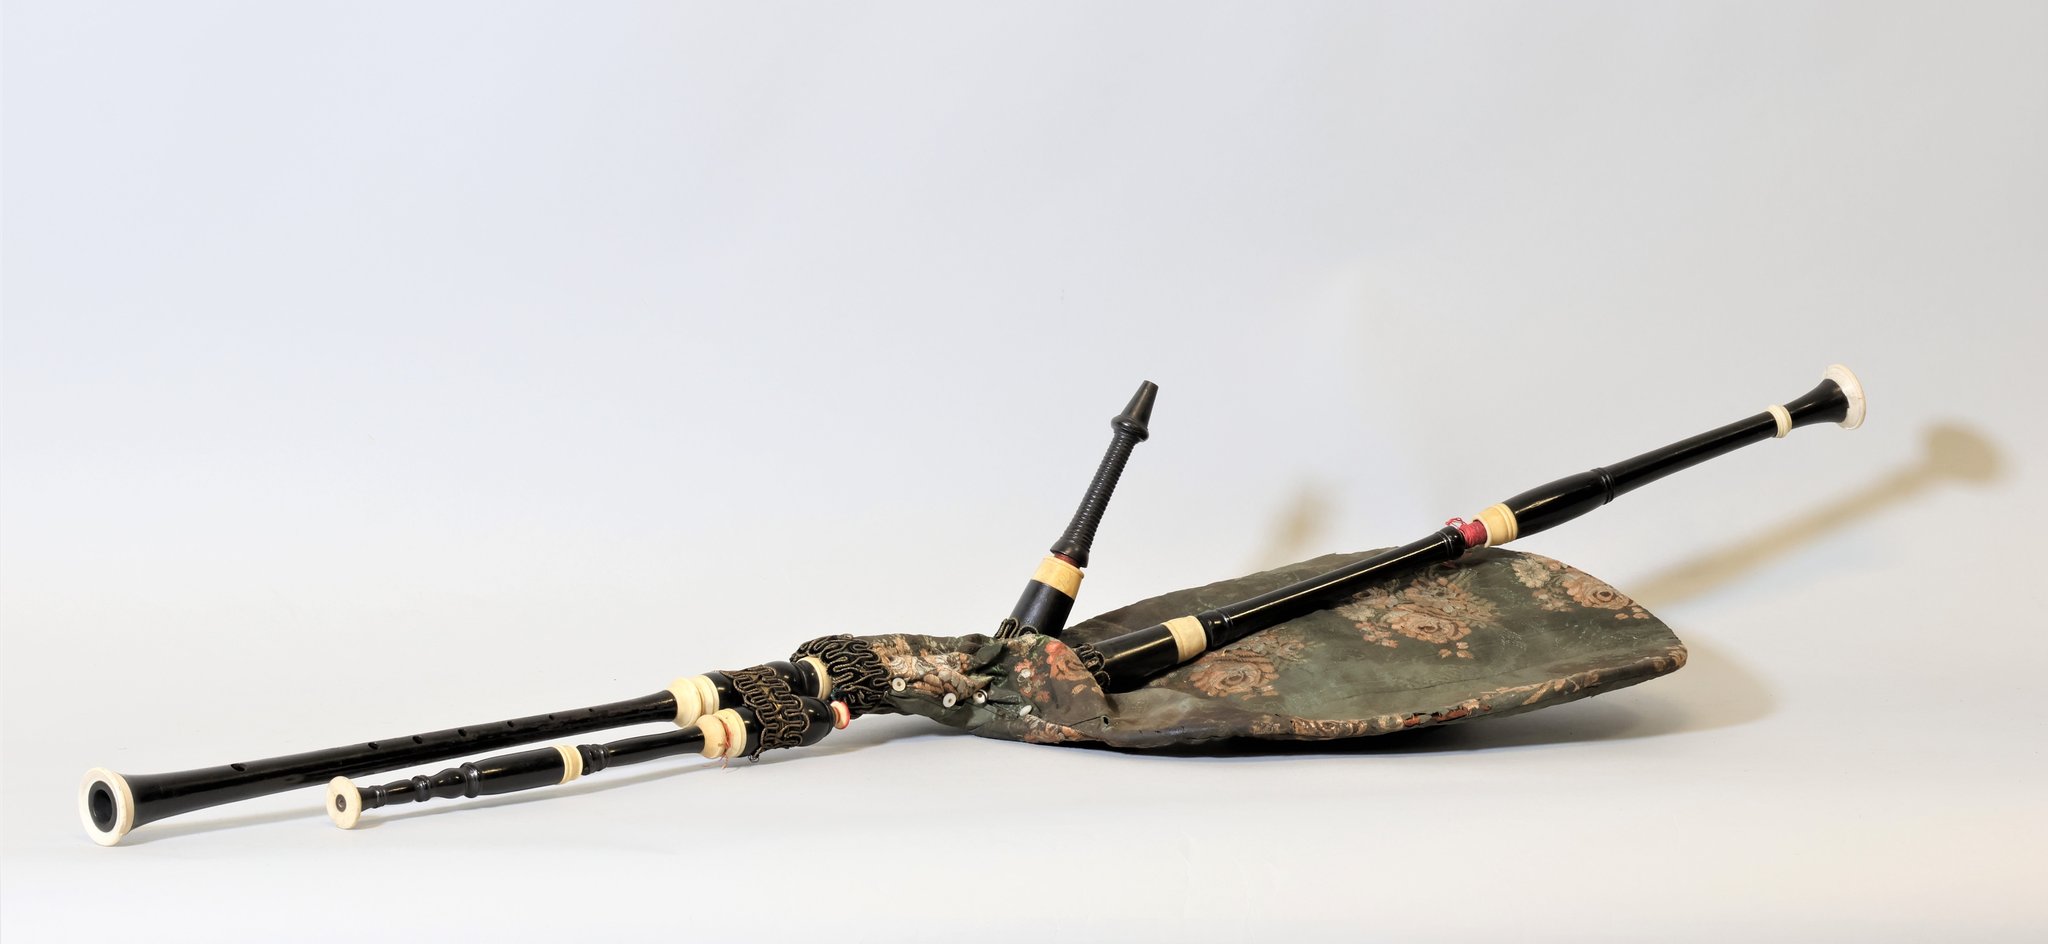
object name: cabrette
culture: french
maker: jean-baptiste pajot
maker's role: maker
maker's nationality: french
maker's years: 1863-1935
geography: france